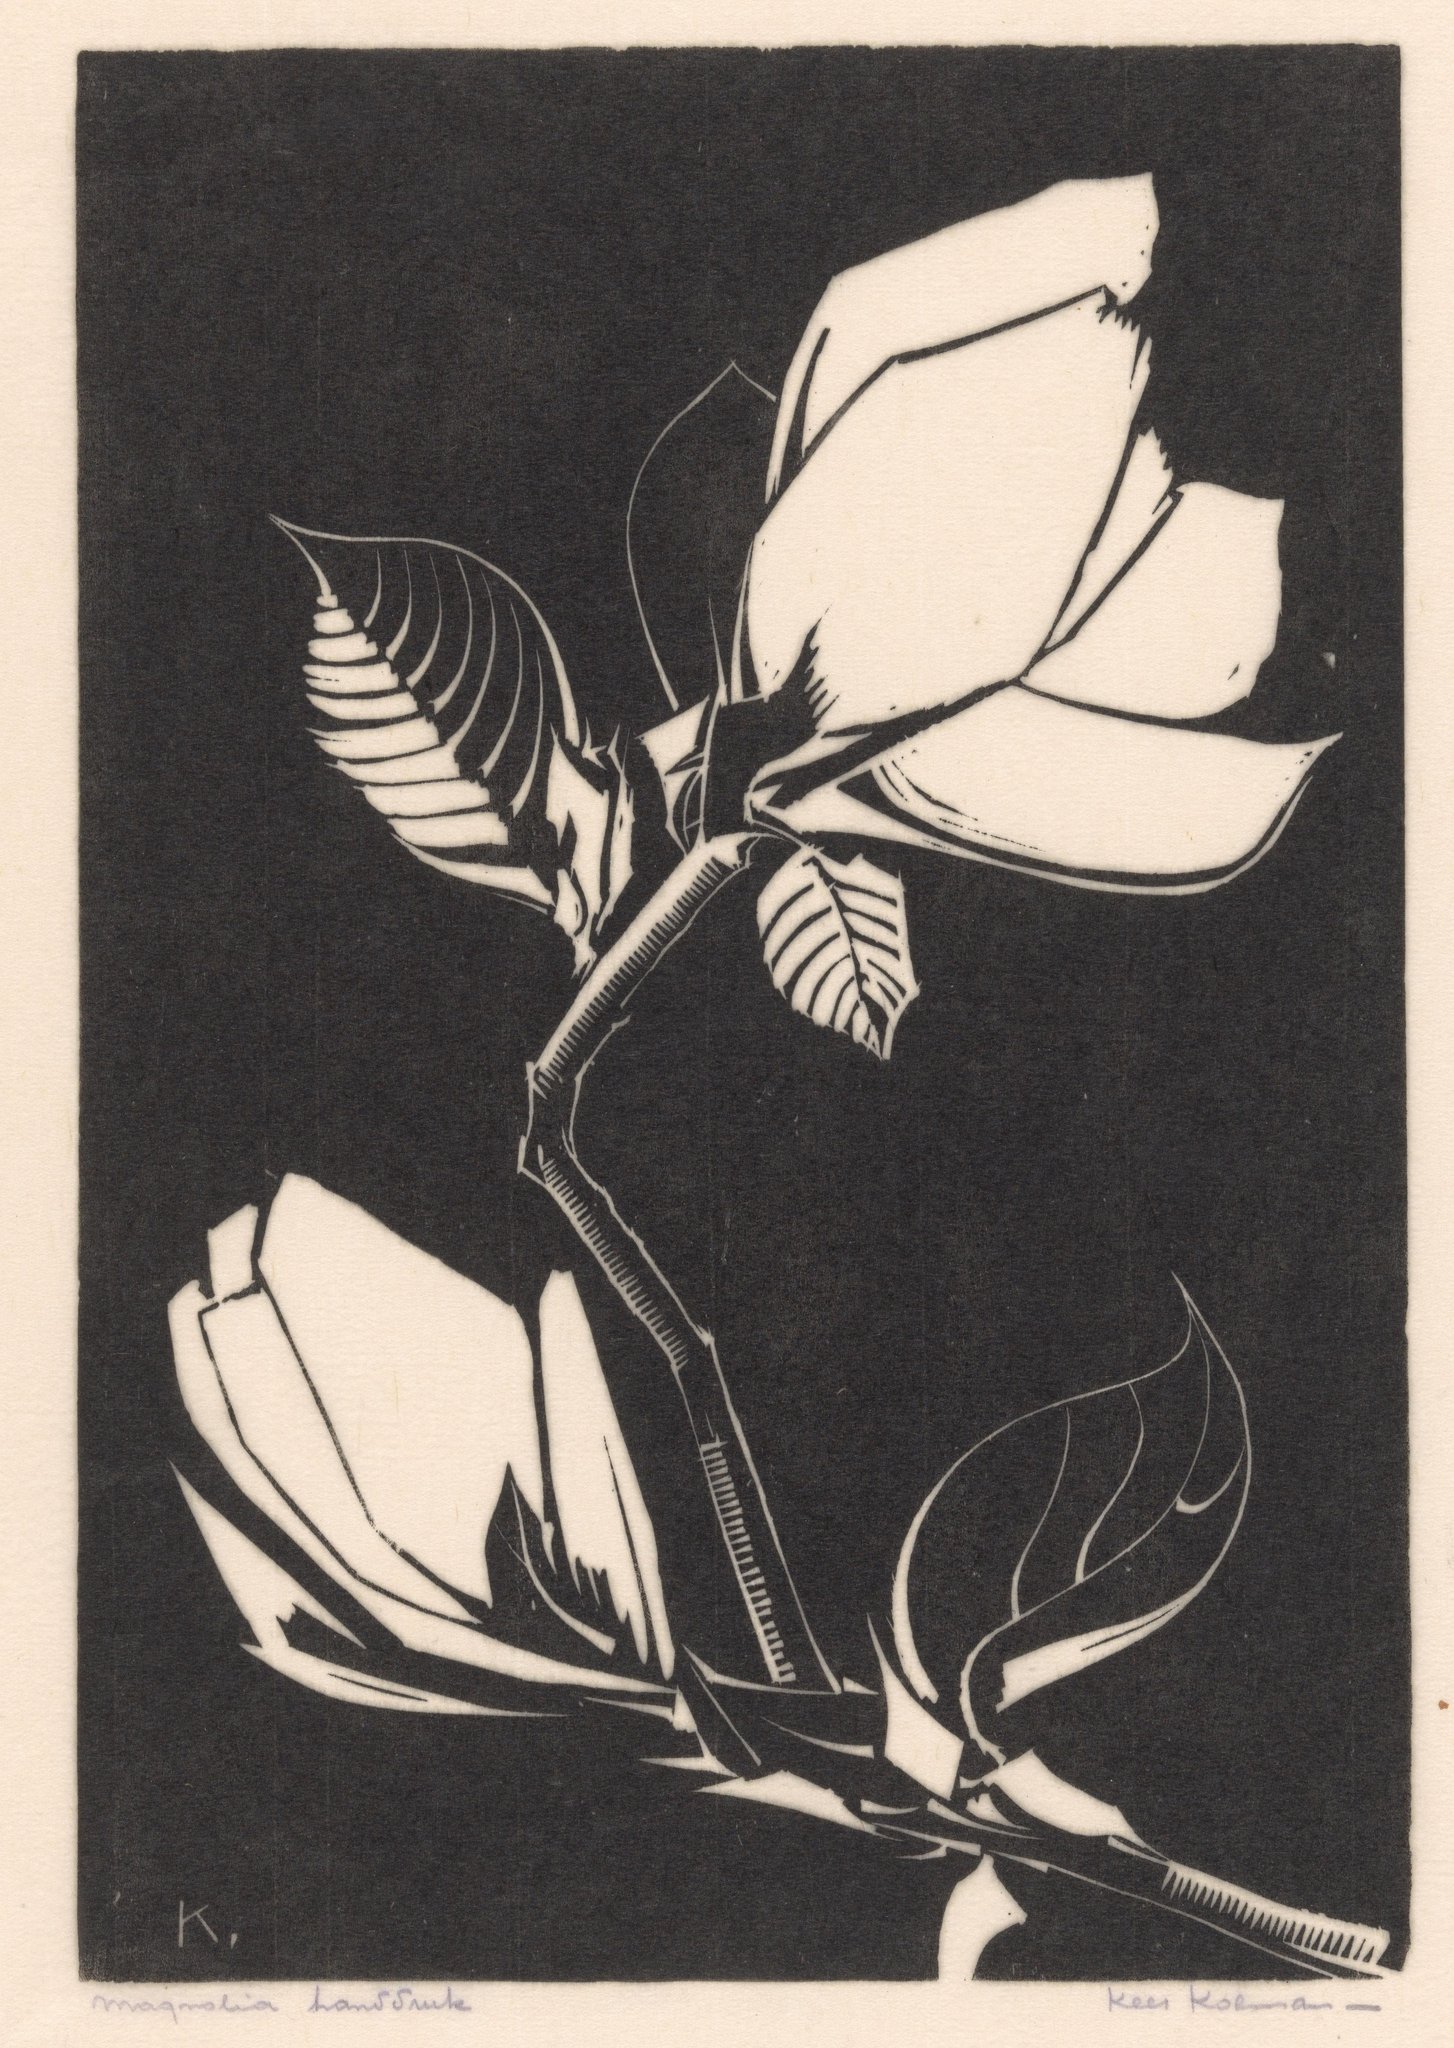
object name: print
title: Magnolia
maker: kees koeman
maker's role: print maker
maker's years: 1895-1954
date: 1910-1932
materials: paper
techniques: woodcut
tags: flowers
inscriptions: collector's mark: Lugt 2228